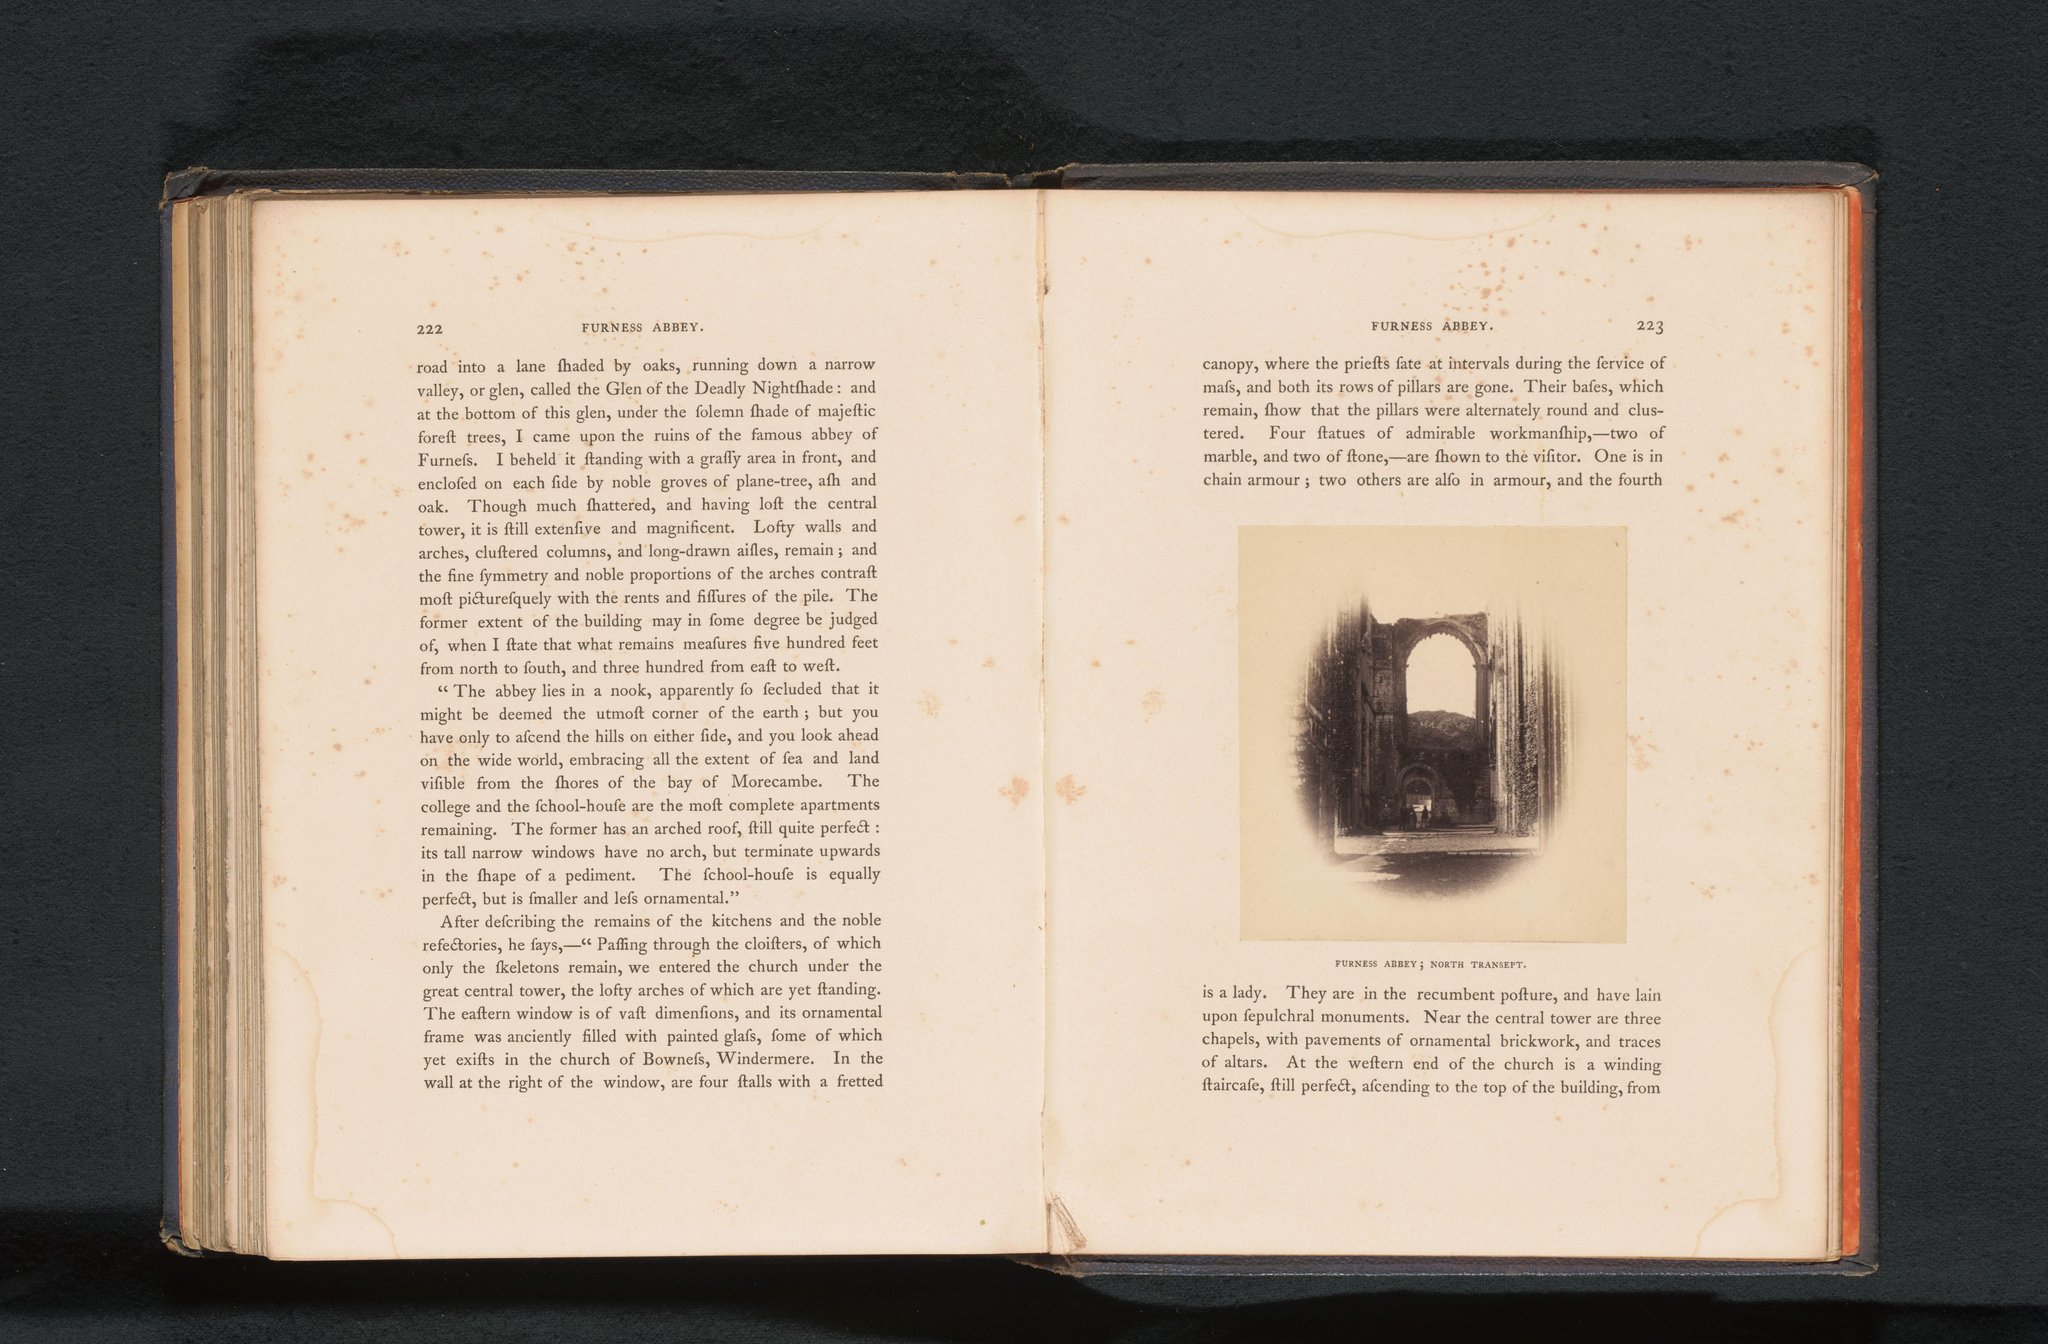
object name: photograph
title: Noordelijk transept van de Abdij van Furness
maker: roger fenton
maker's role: fotograaf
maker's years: 1819-1869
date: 1857-1862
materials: photographic support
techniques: albumen print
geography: rievalx abbey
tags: parts of church interior: transept, ruin of church, monastery, etc.